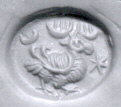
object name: stamp seal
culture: sasanian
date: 401-500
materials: stone, quartz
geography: iran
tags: birds